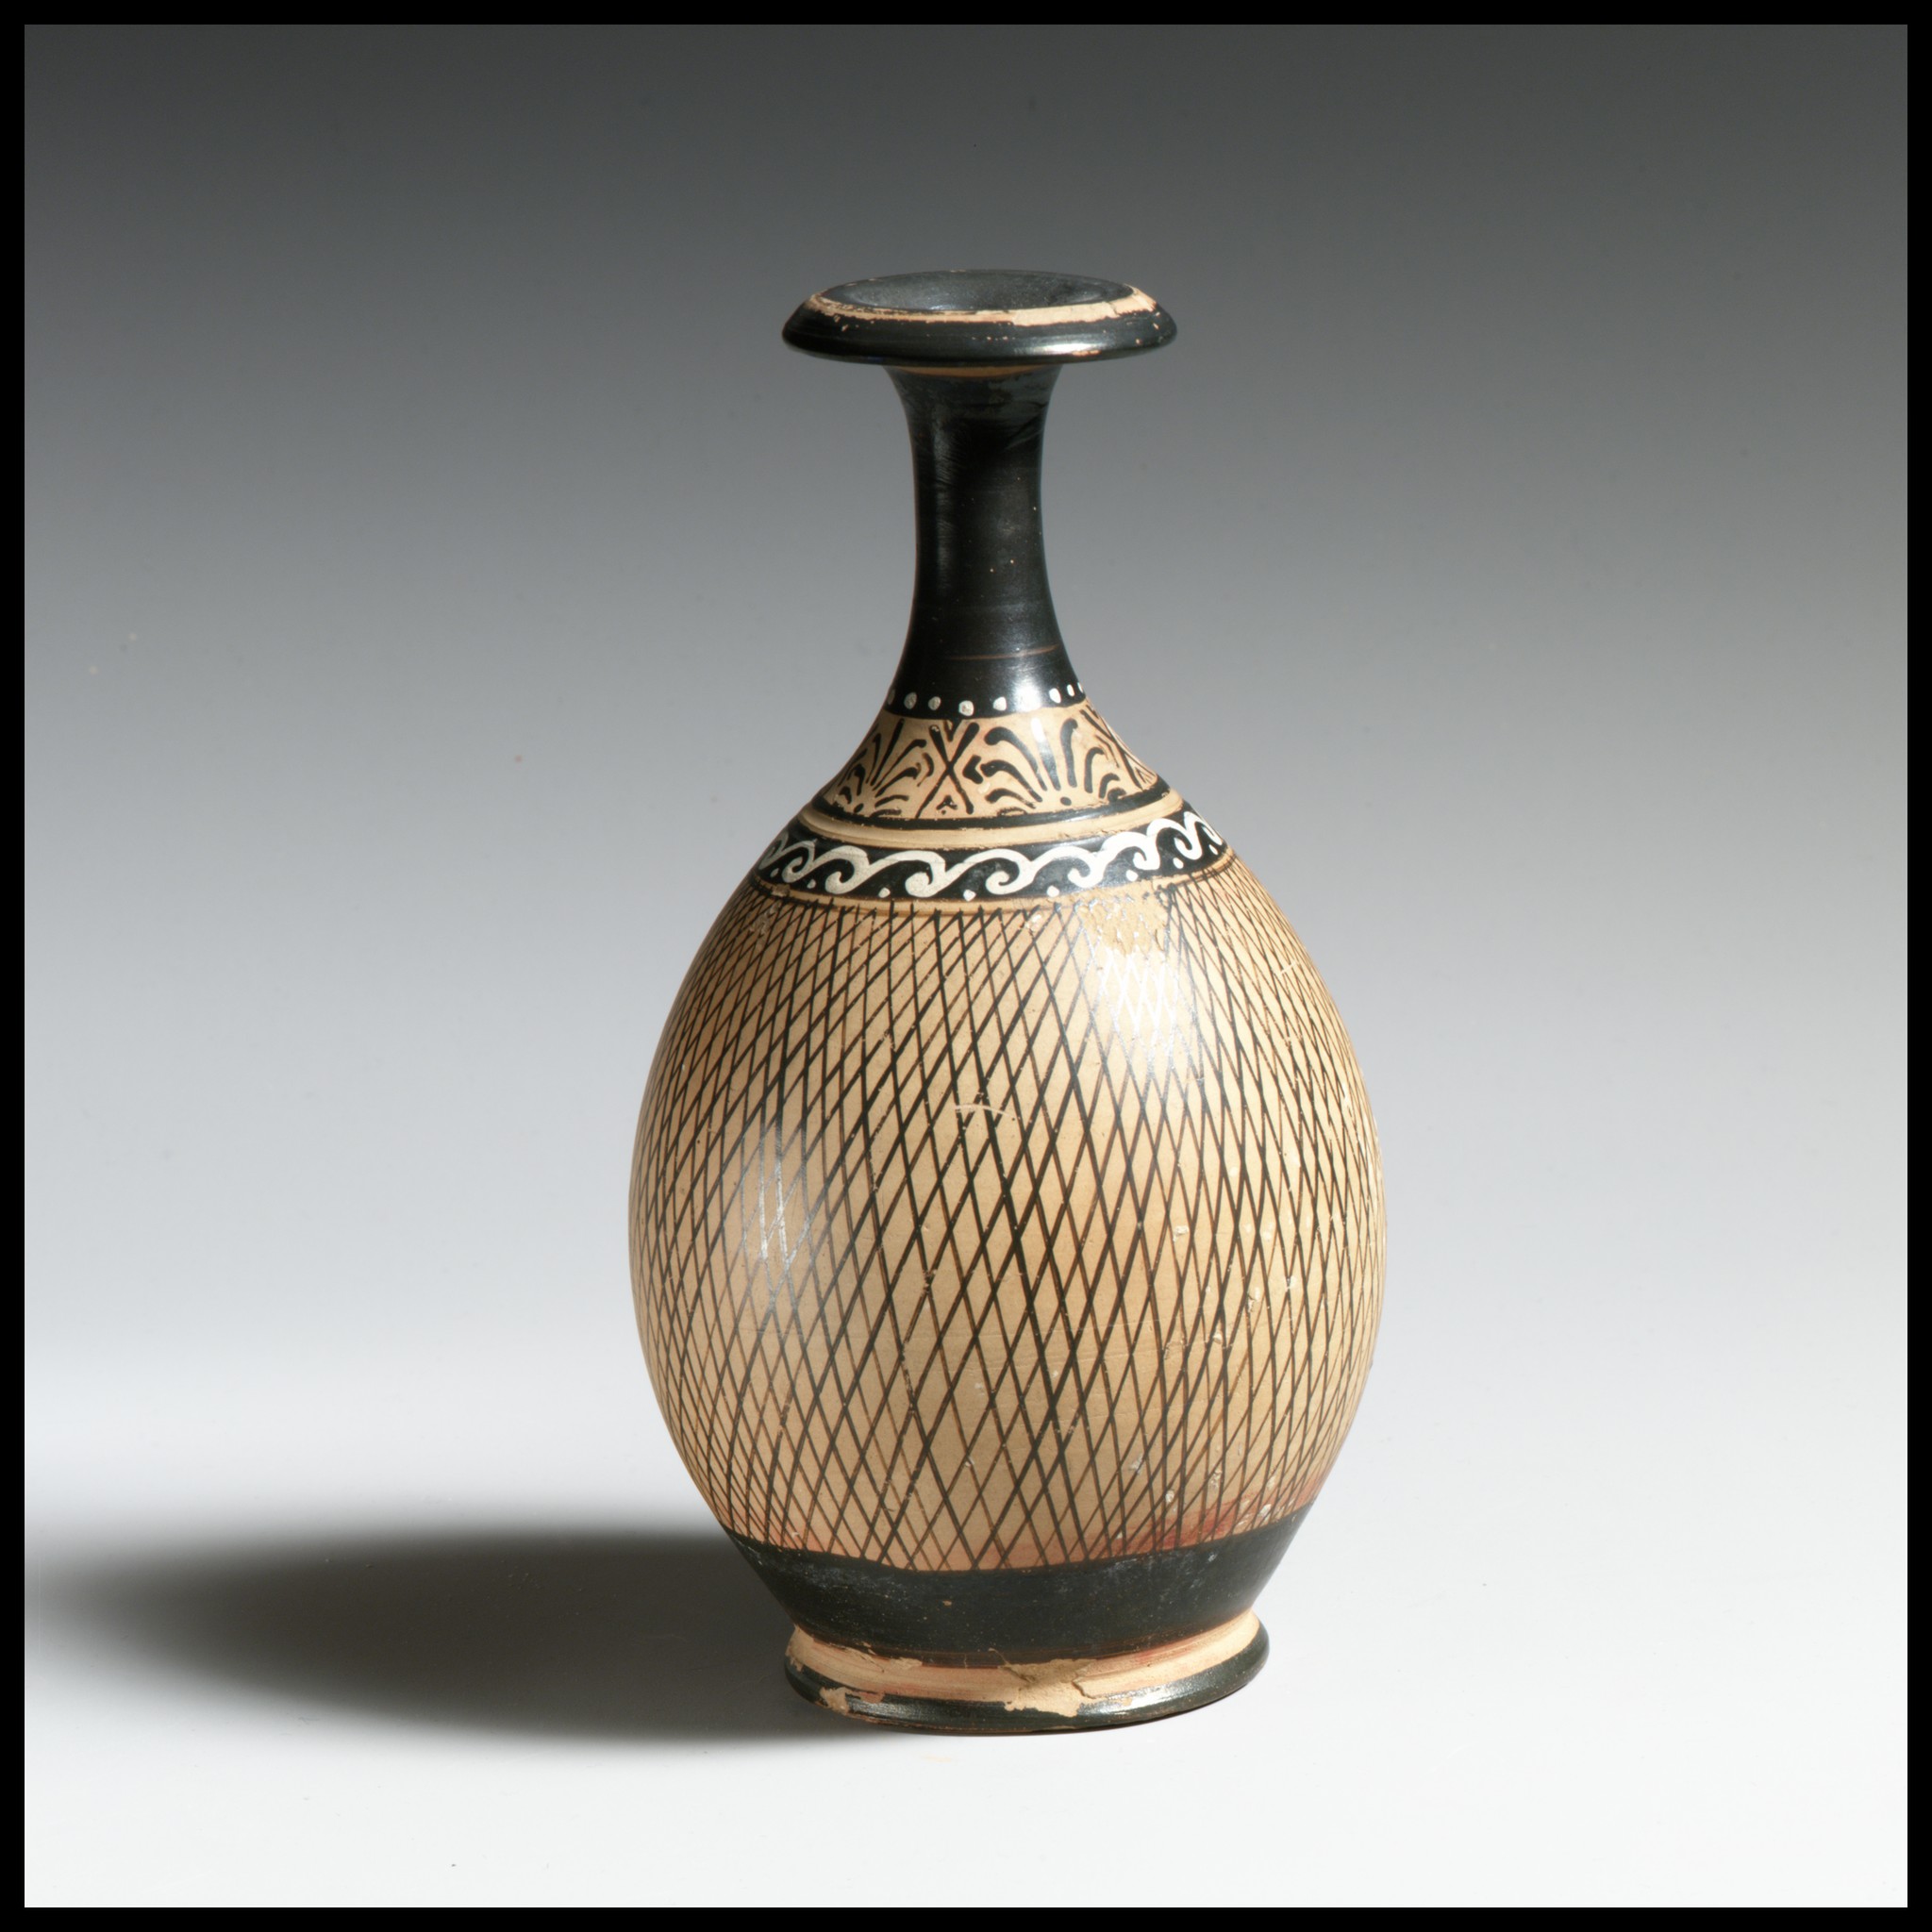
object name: bottle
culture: greek, south italian, apulian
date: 400-301 BCE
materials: terracotta